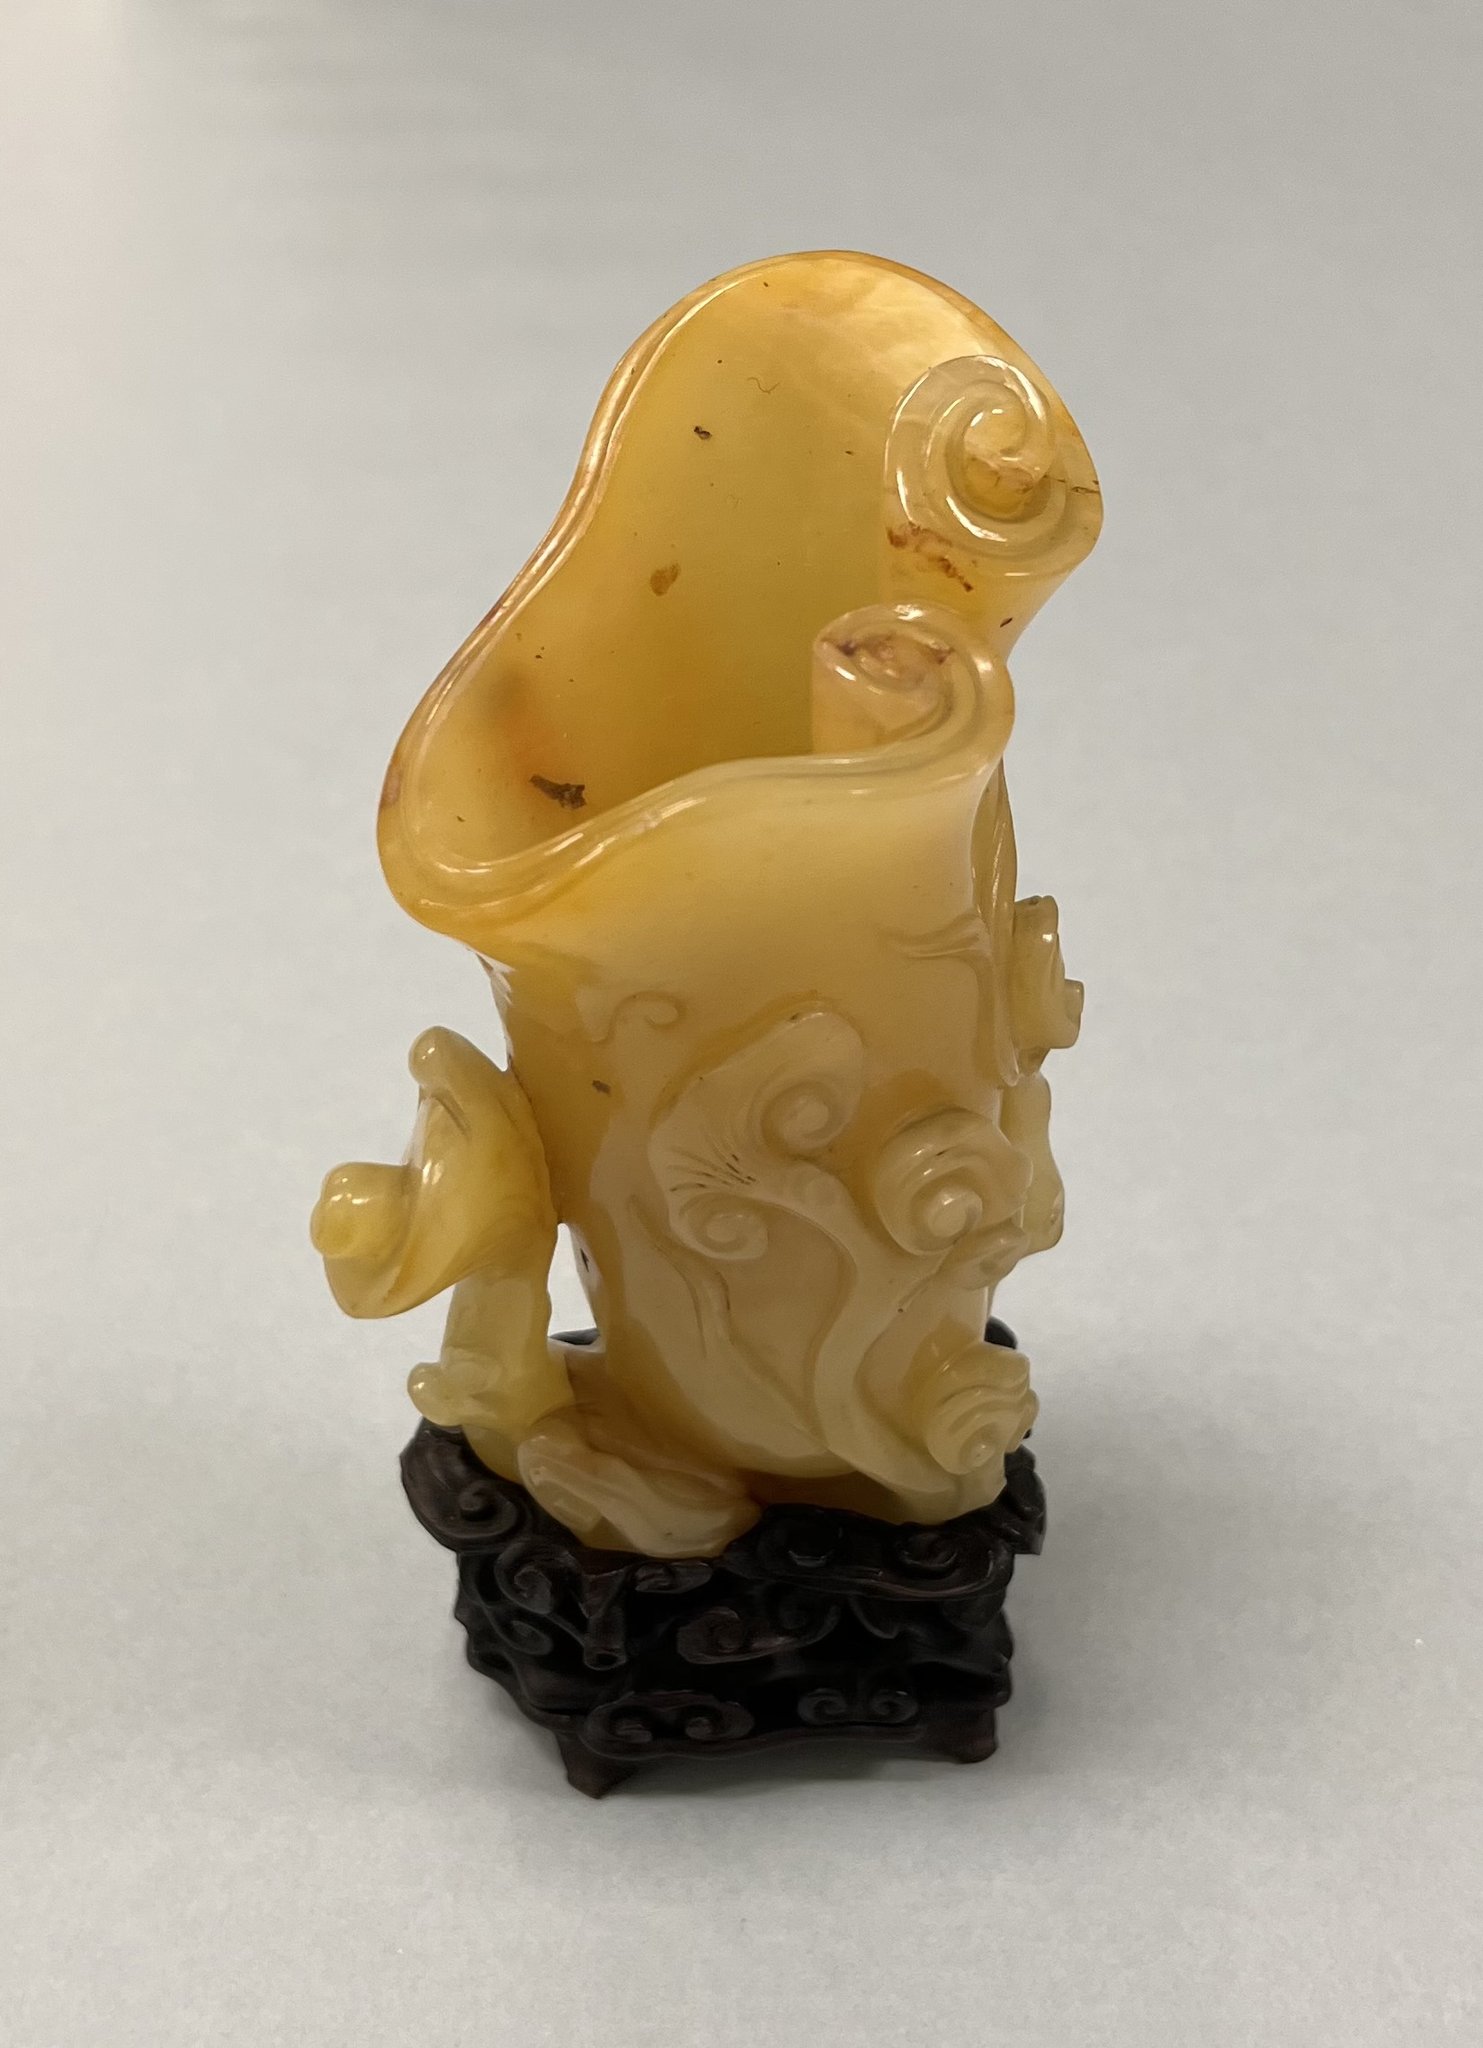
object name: vase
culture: chinese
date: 1701-1800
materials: stone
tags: plants